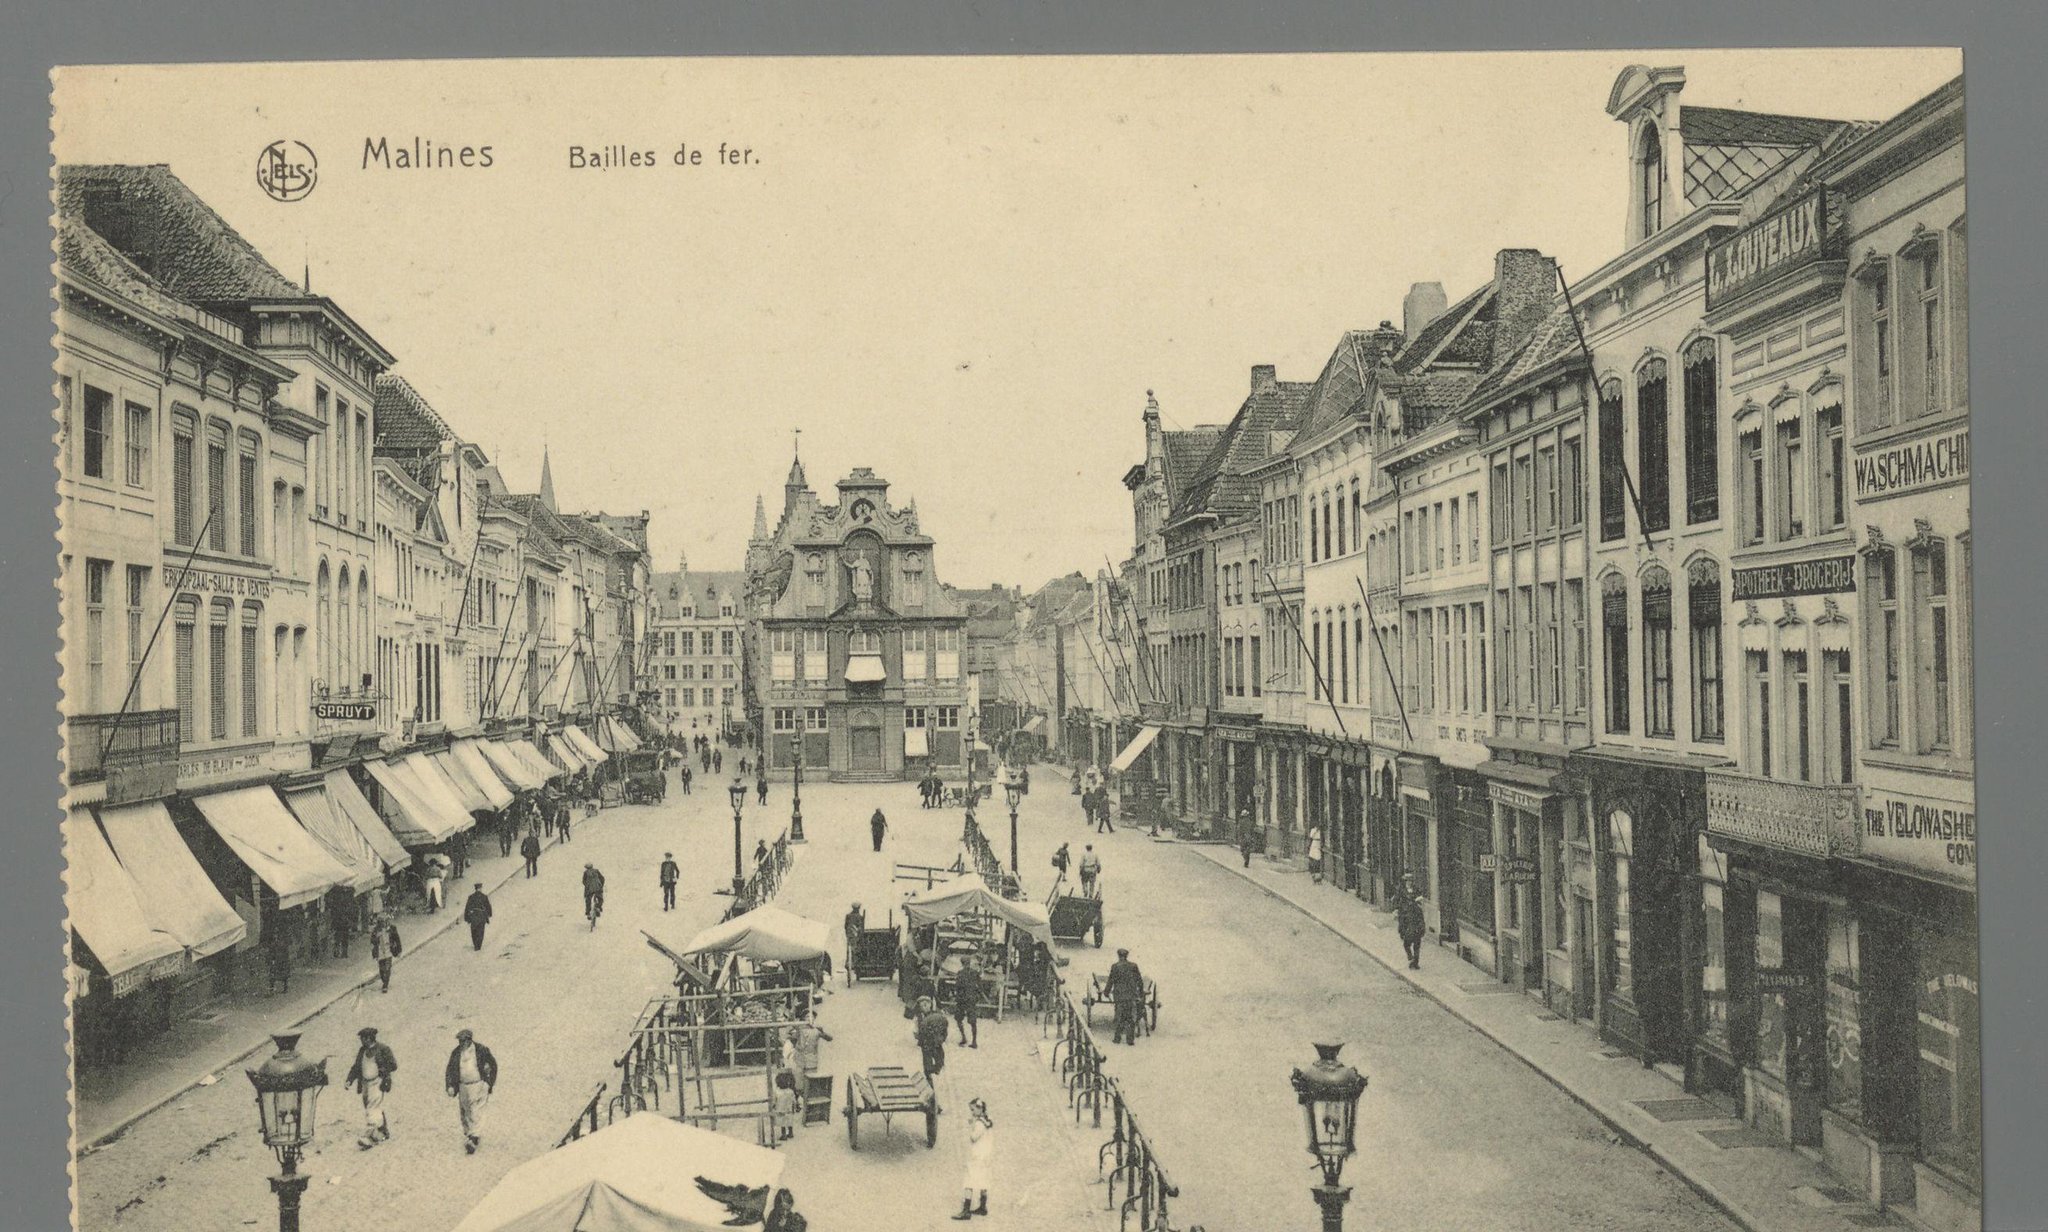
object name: photomechanical print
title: Malines. Bailles de fer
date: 1913-1914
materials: cardboard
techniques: photograph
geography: brussels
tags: urban housing, corporative organization, guild, square, place, circus, etc. (+ city(-scape) with figures, staffage), mechelen